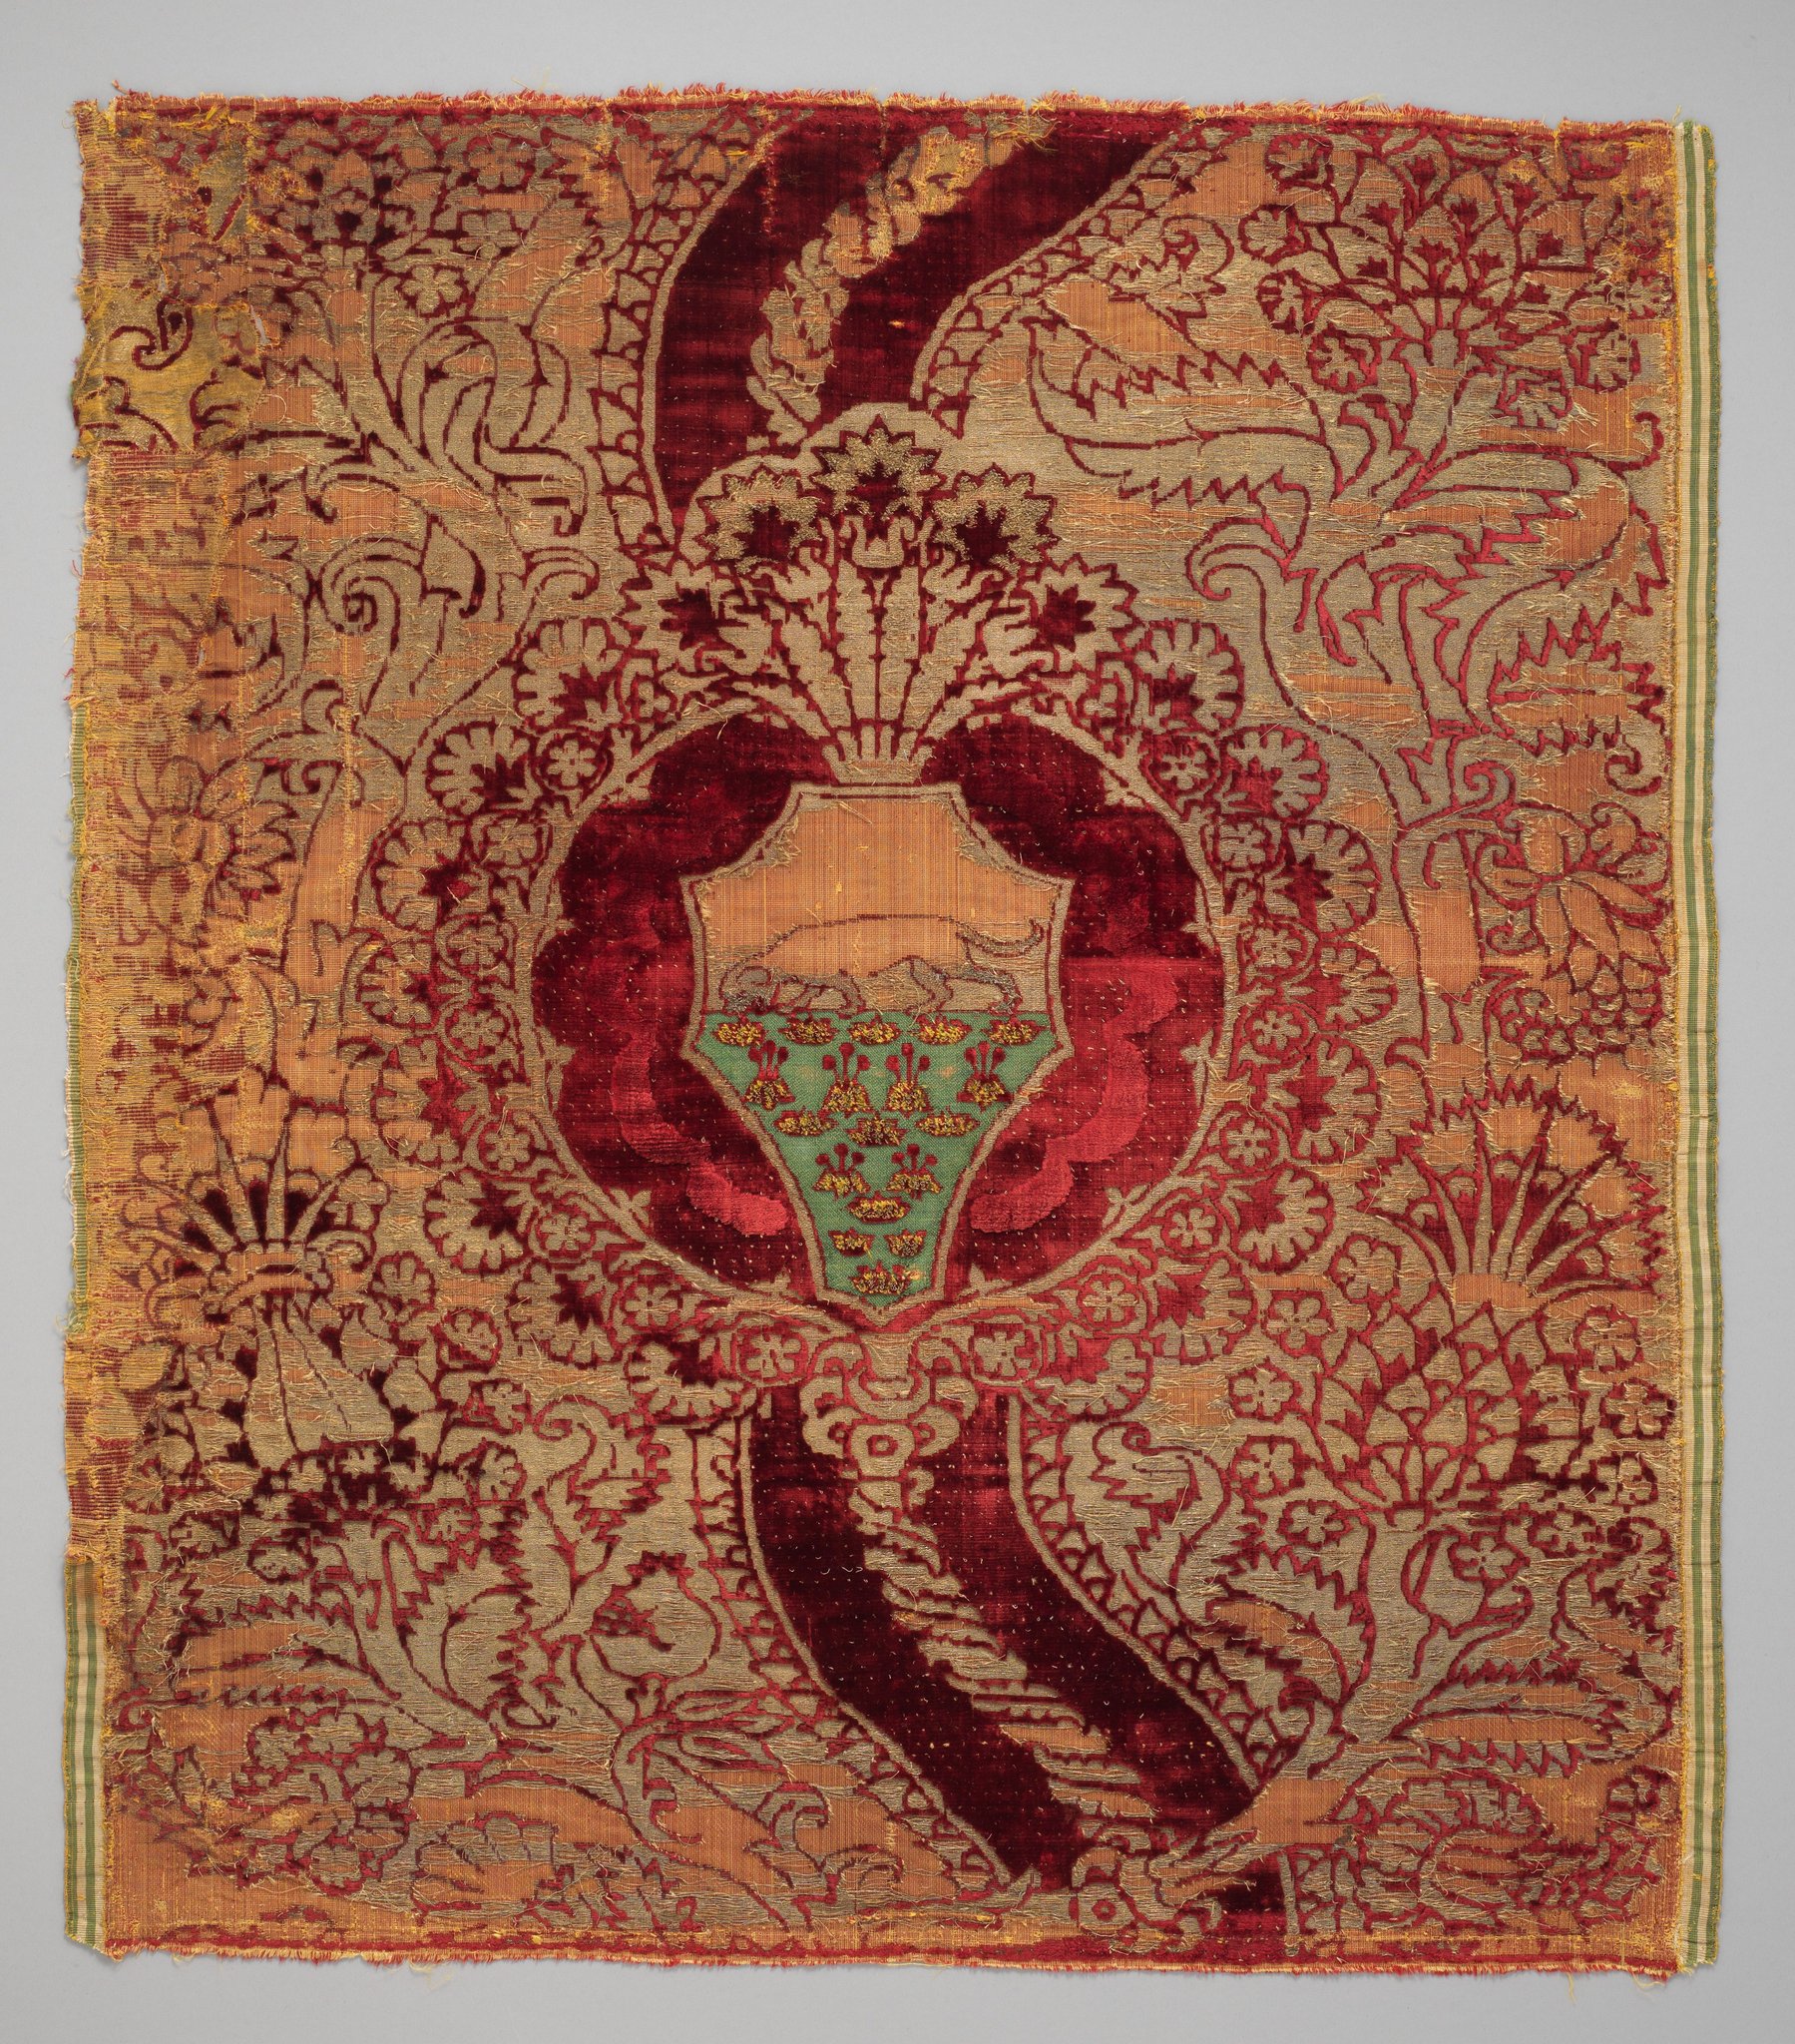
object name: piece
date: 1451-1500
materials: metal thread, silk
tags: animals,flowers